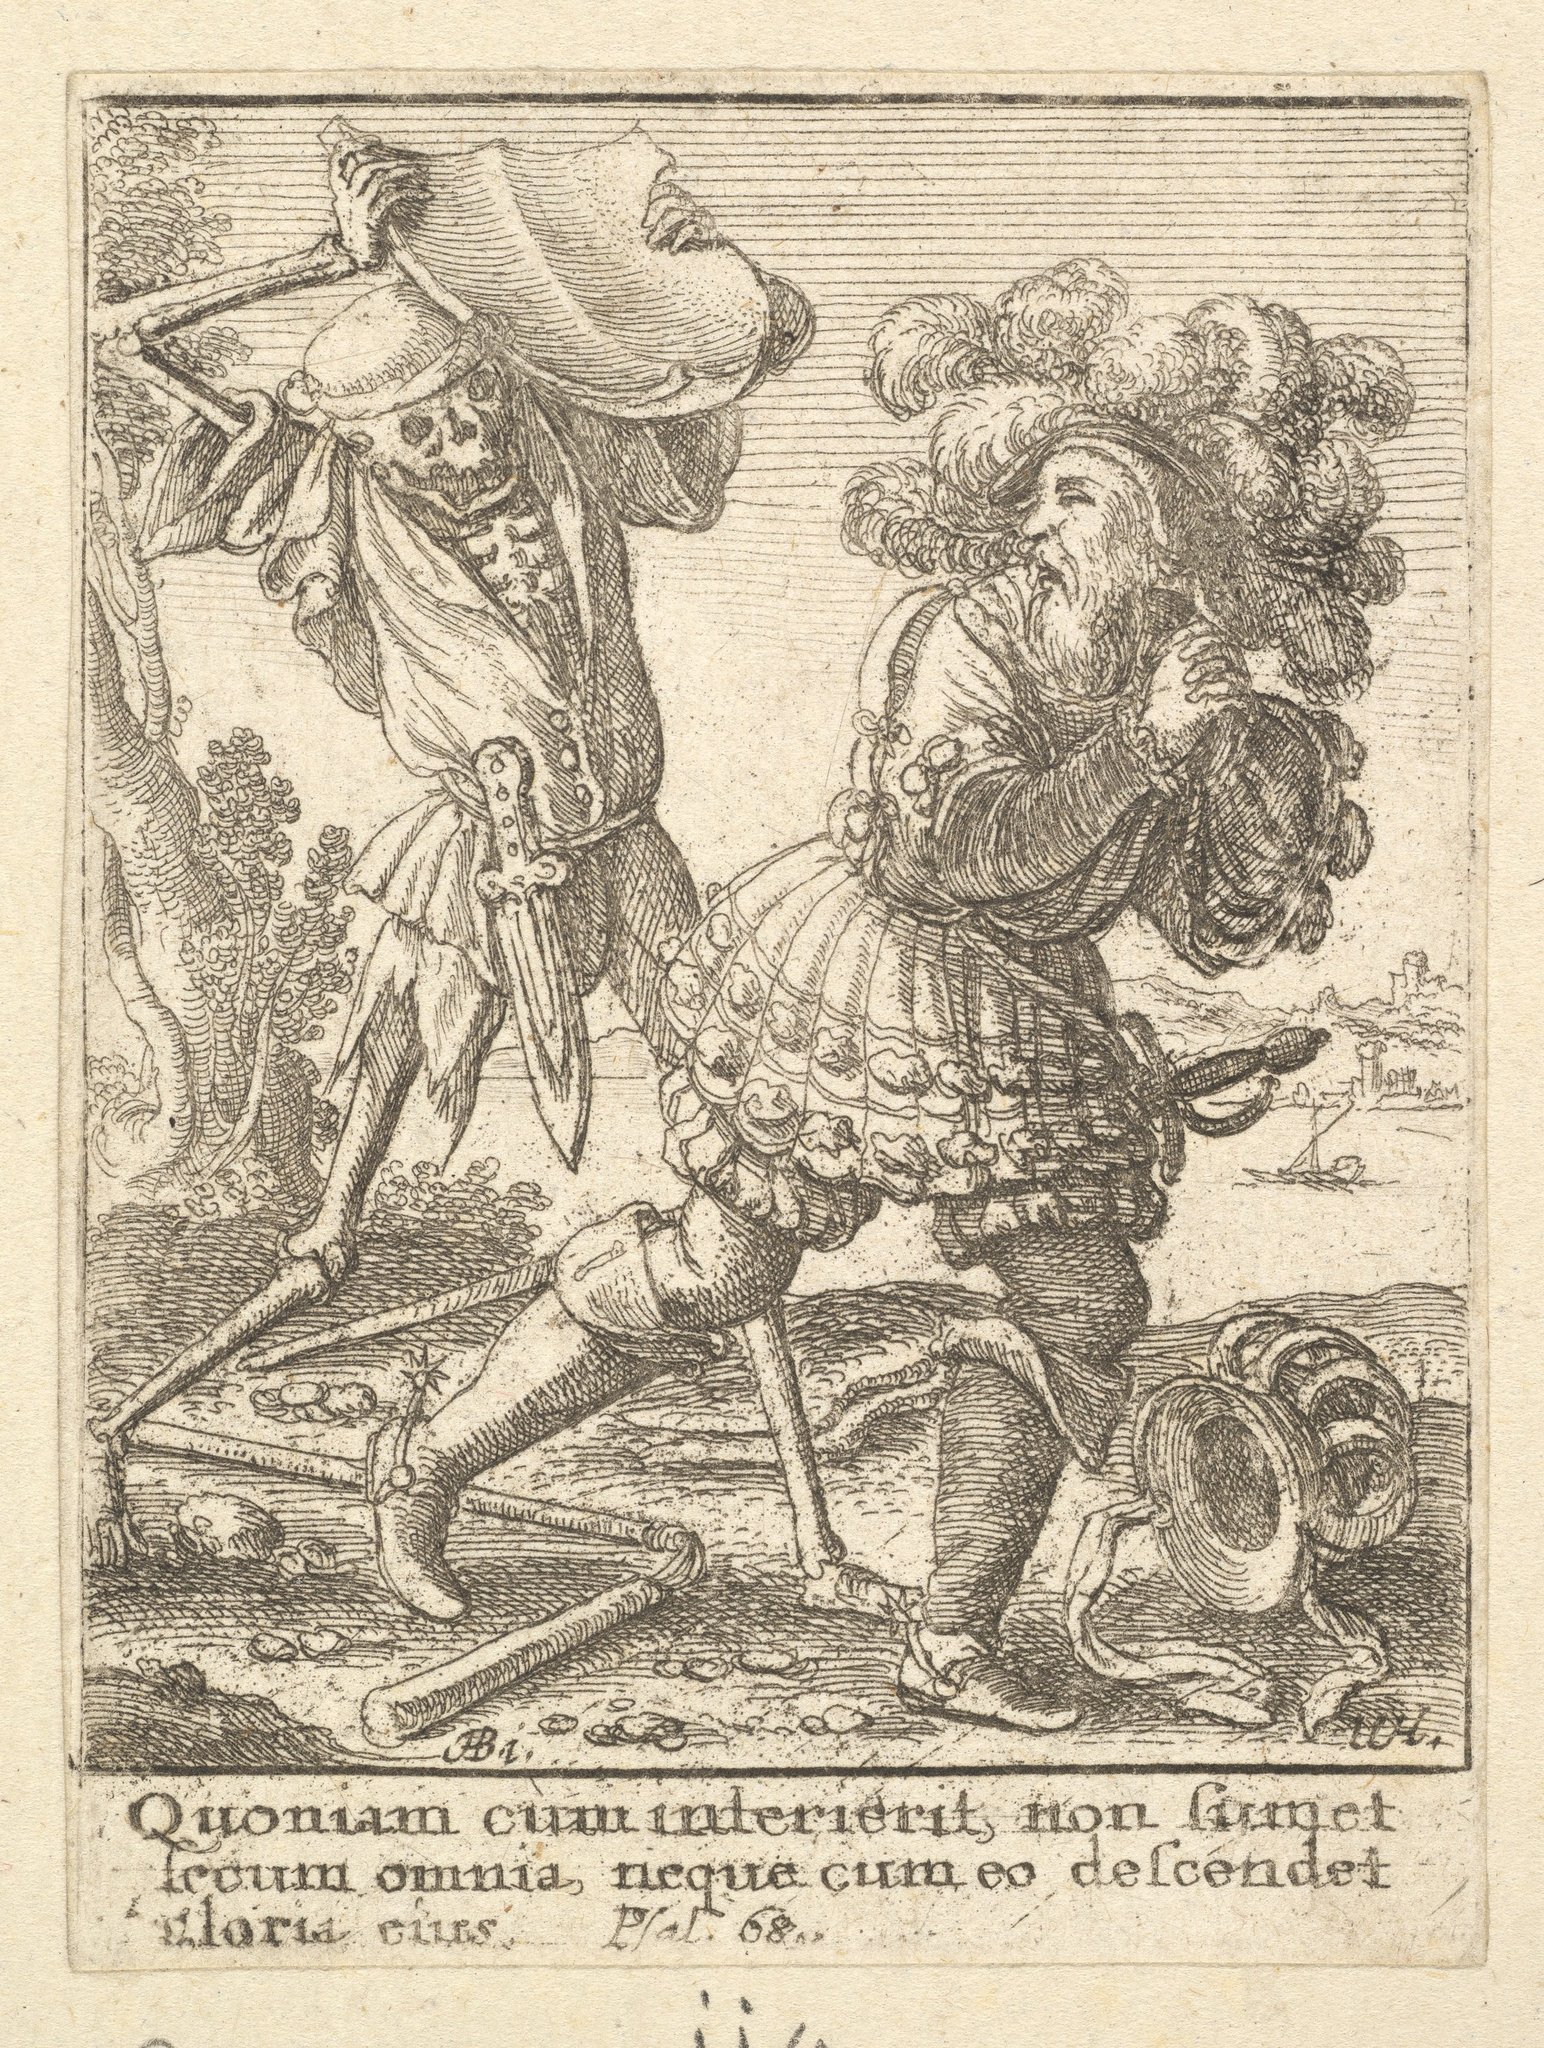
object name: print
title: The Count from the Dance of Death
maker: wenceslaus hollar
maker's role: artist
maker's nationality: bohemian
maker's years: 1607-1677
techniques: etching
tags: shields,daggers,skeletons,men,death